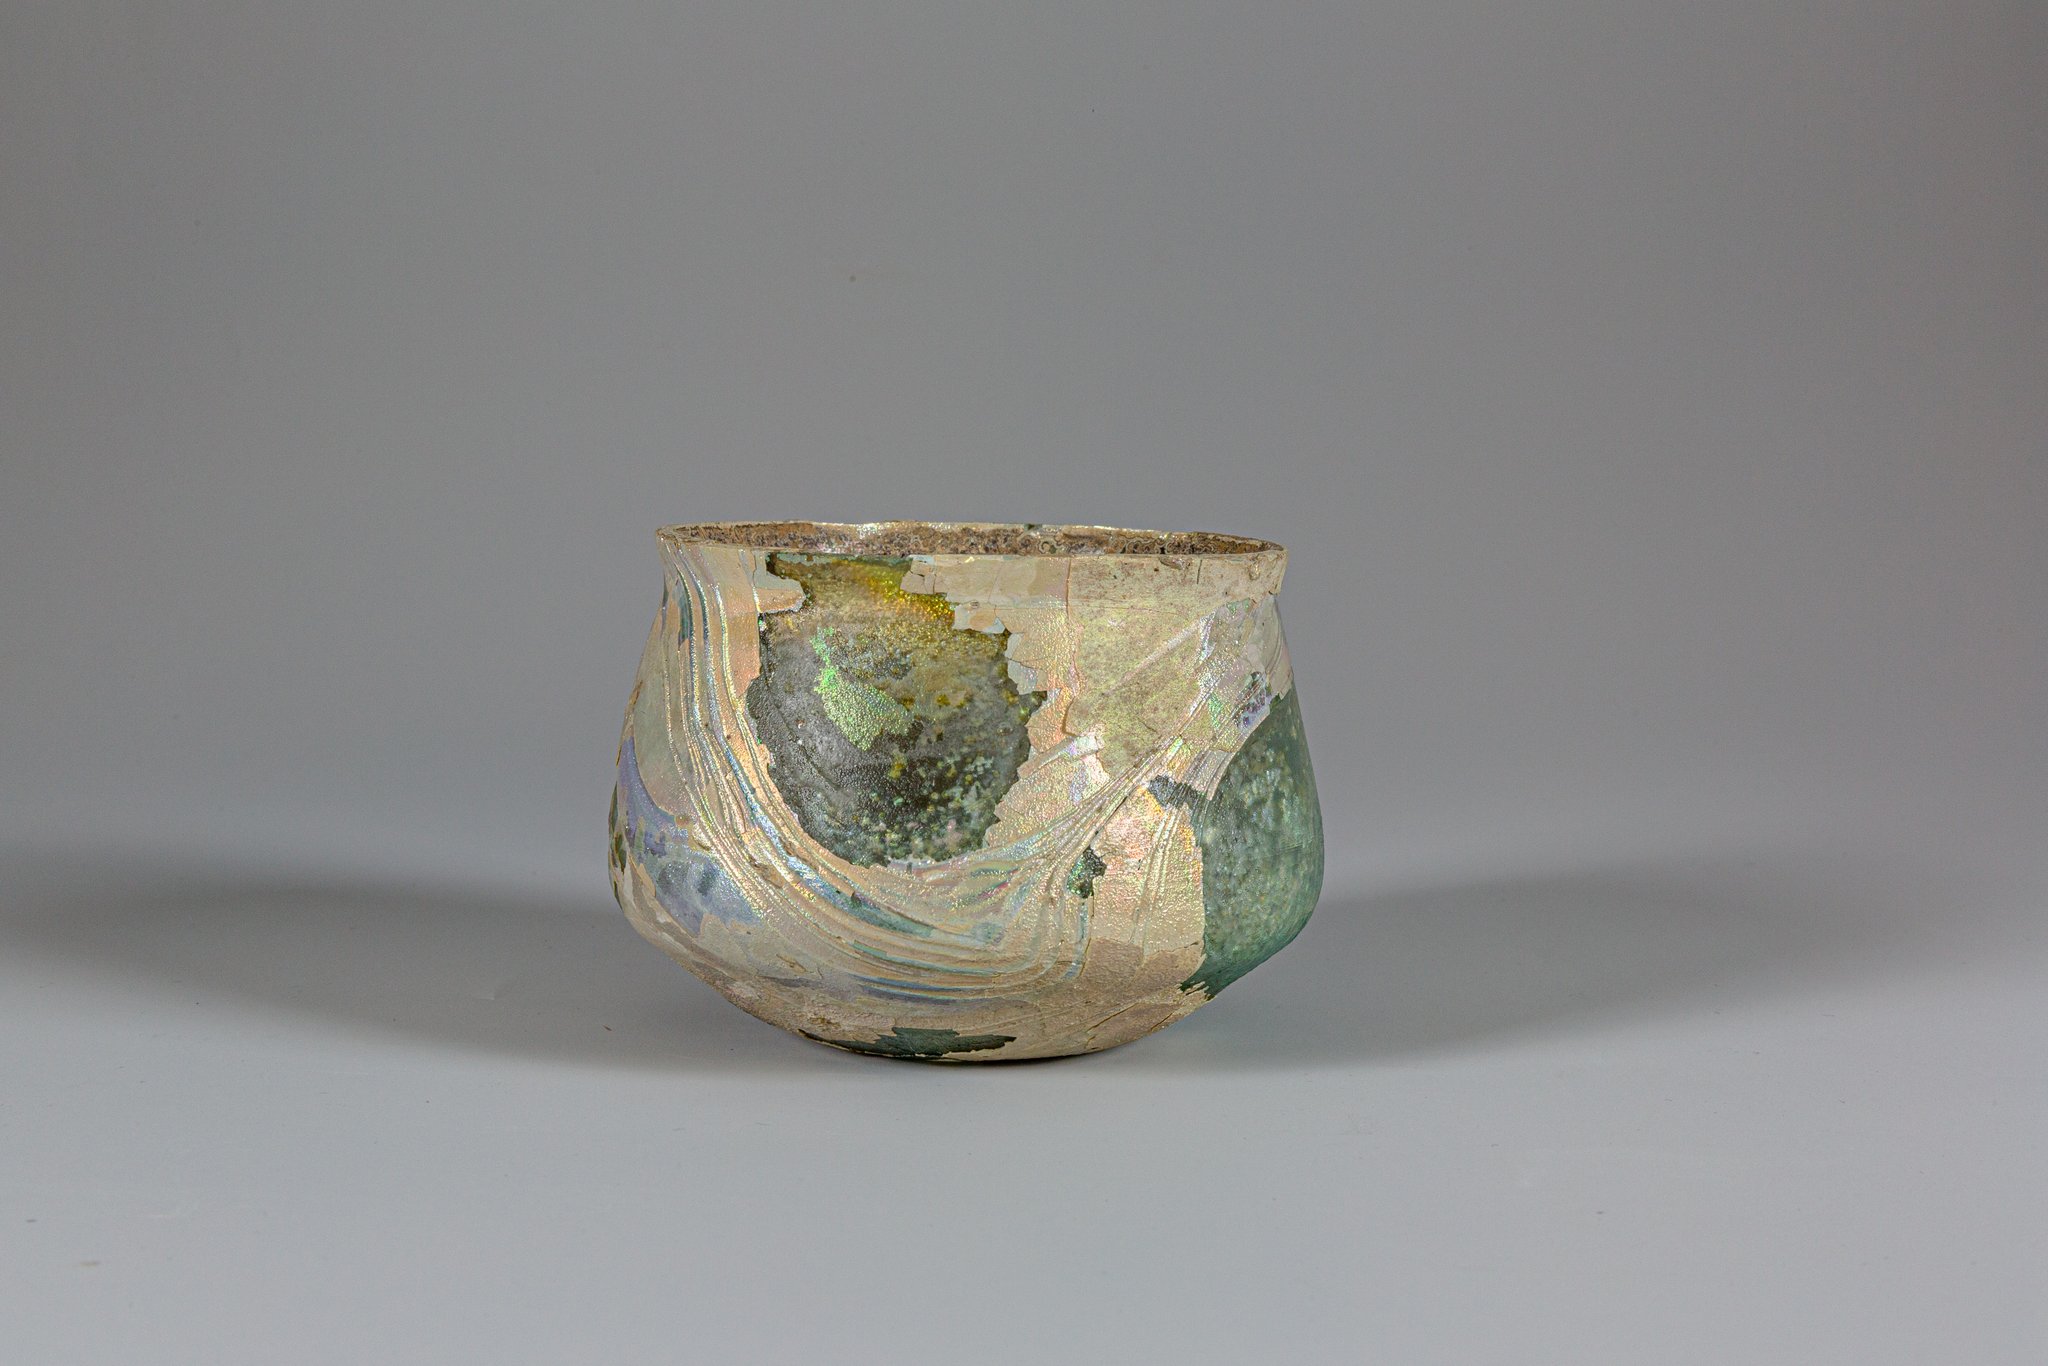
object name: cup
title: Glass cup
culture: roman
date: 1-200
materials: glass